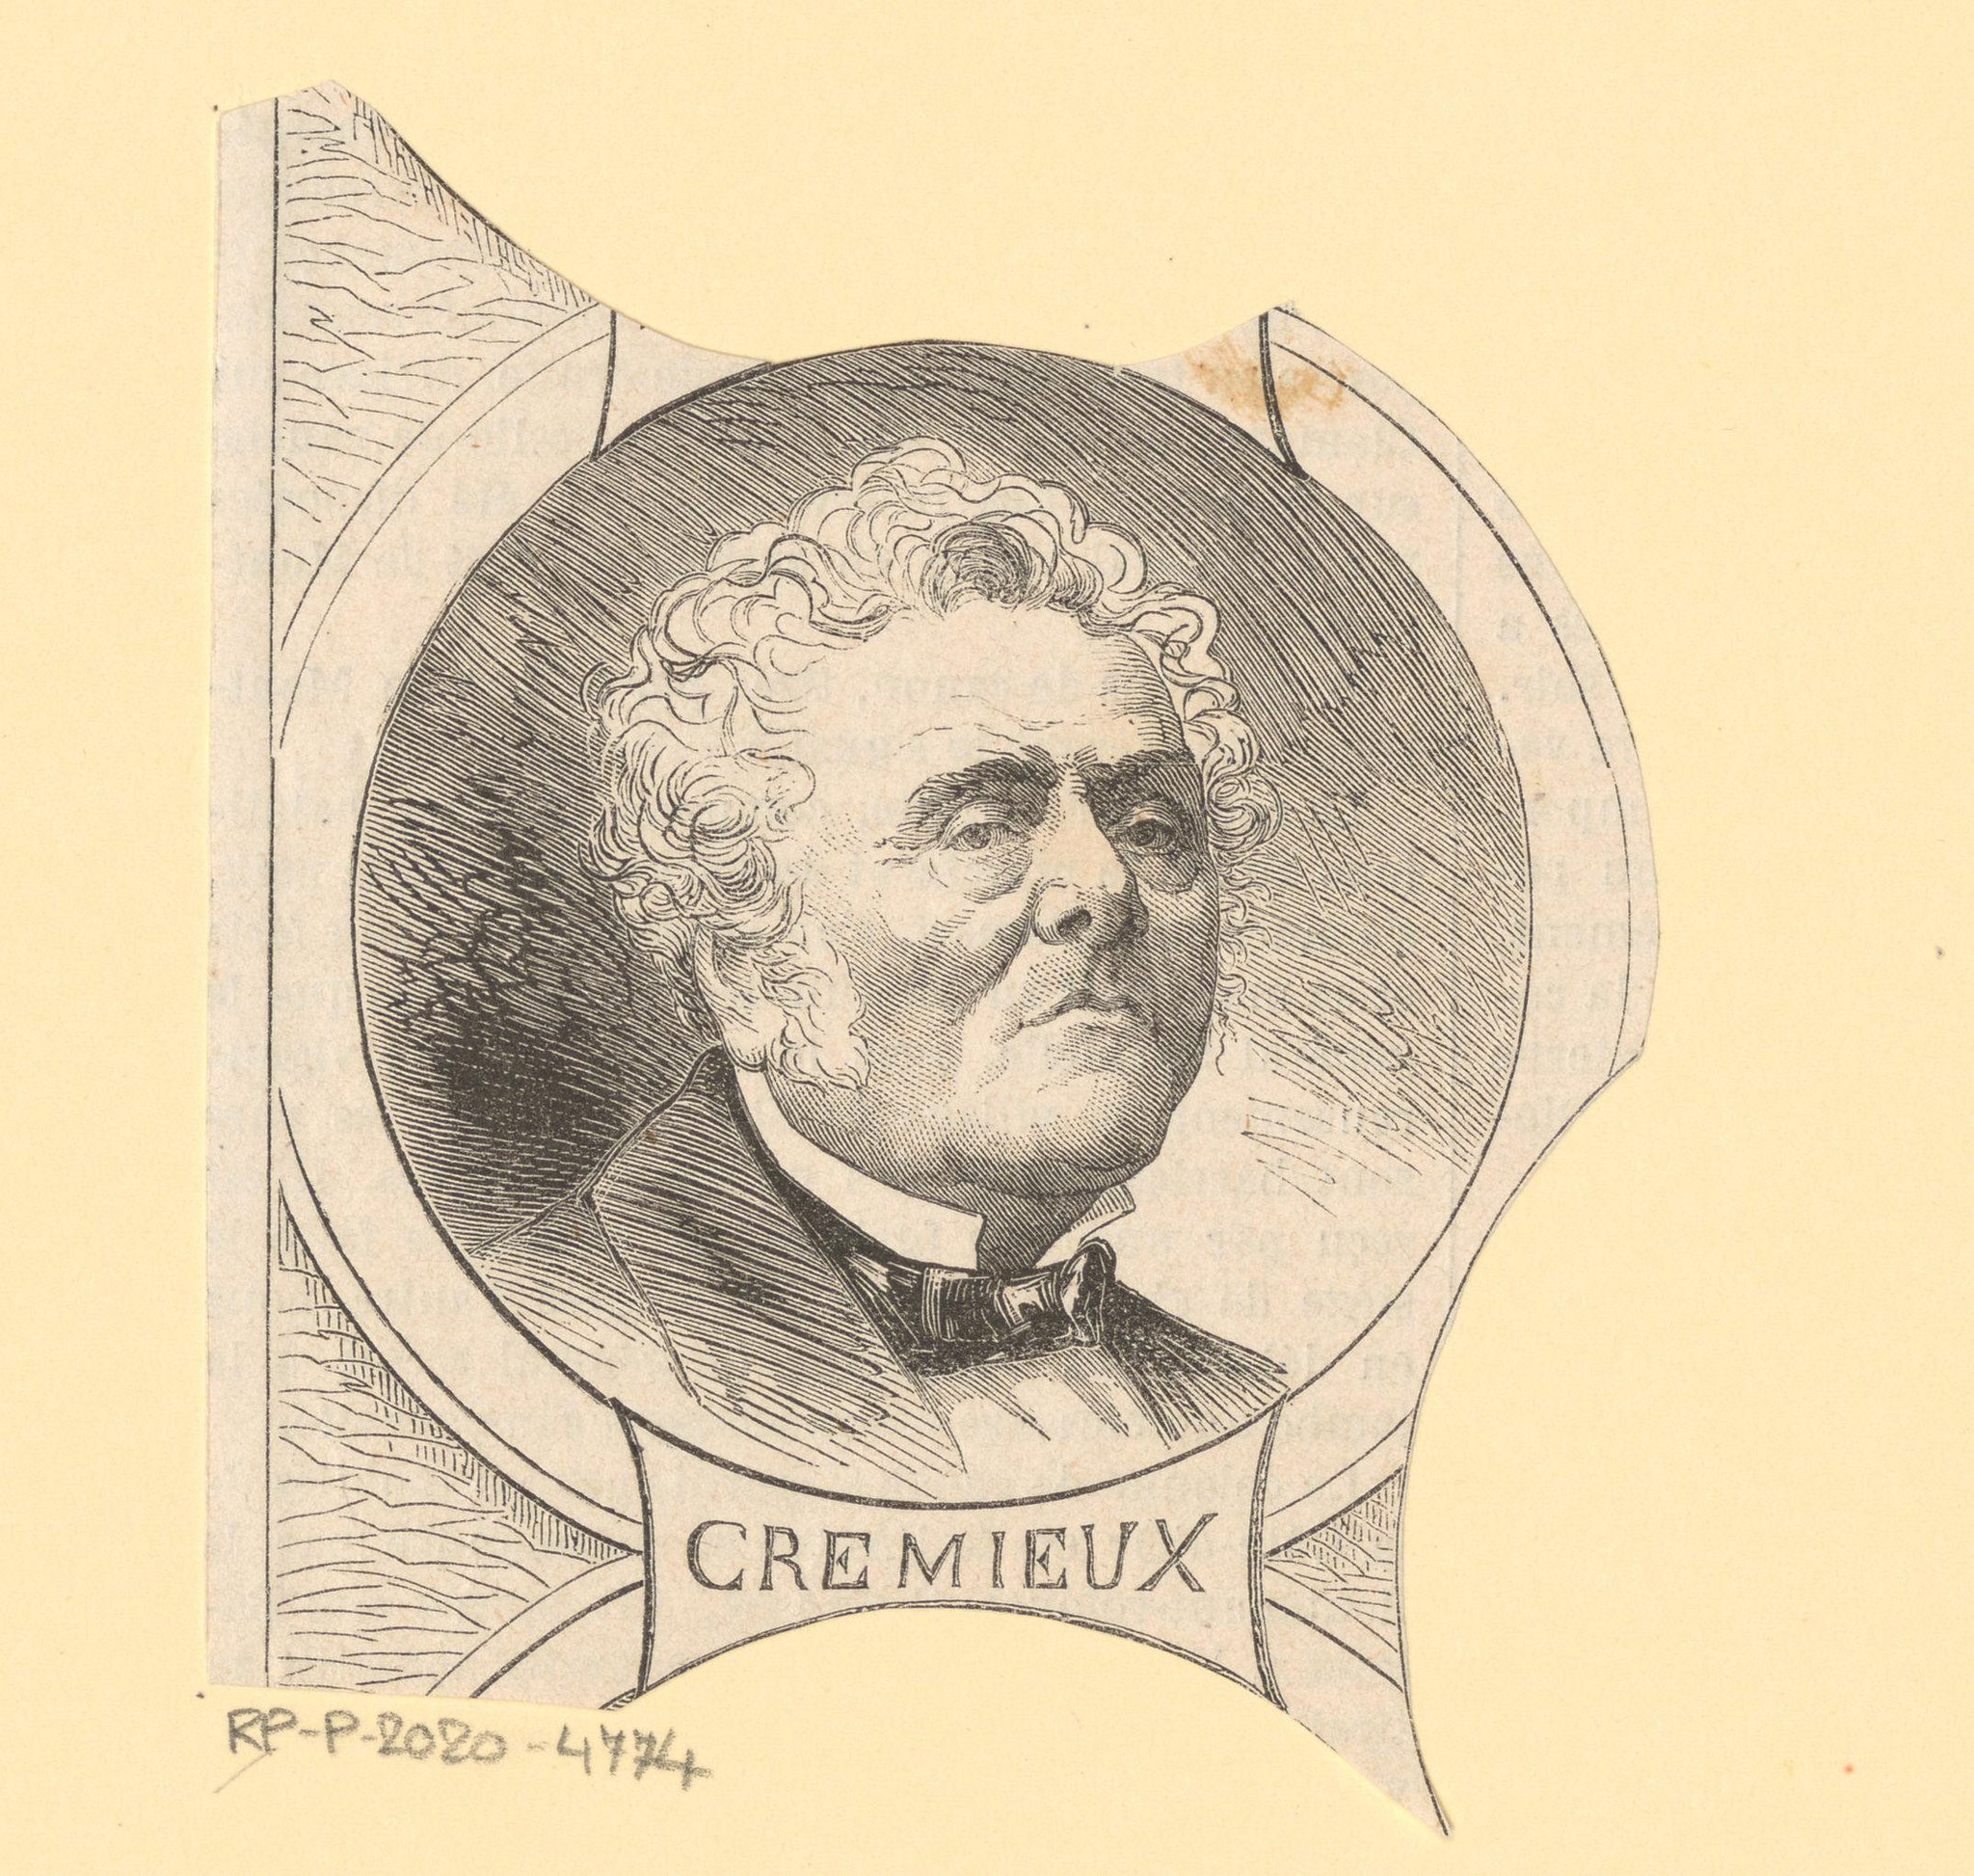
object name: print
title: Portret van Adolphe Crémieux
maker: Anonymous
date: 1836-1899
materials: paper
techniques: letterpress printing, engraving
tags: politician, historical persons